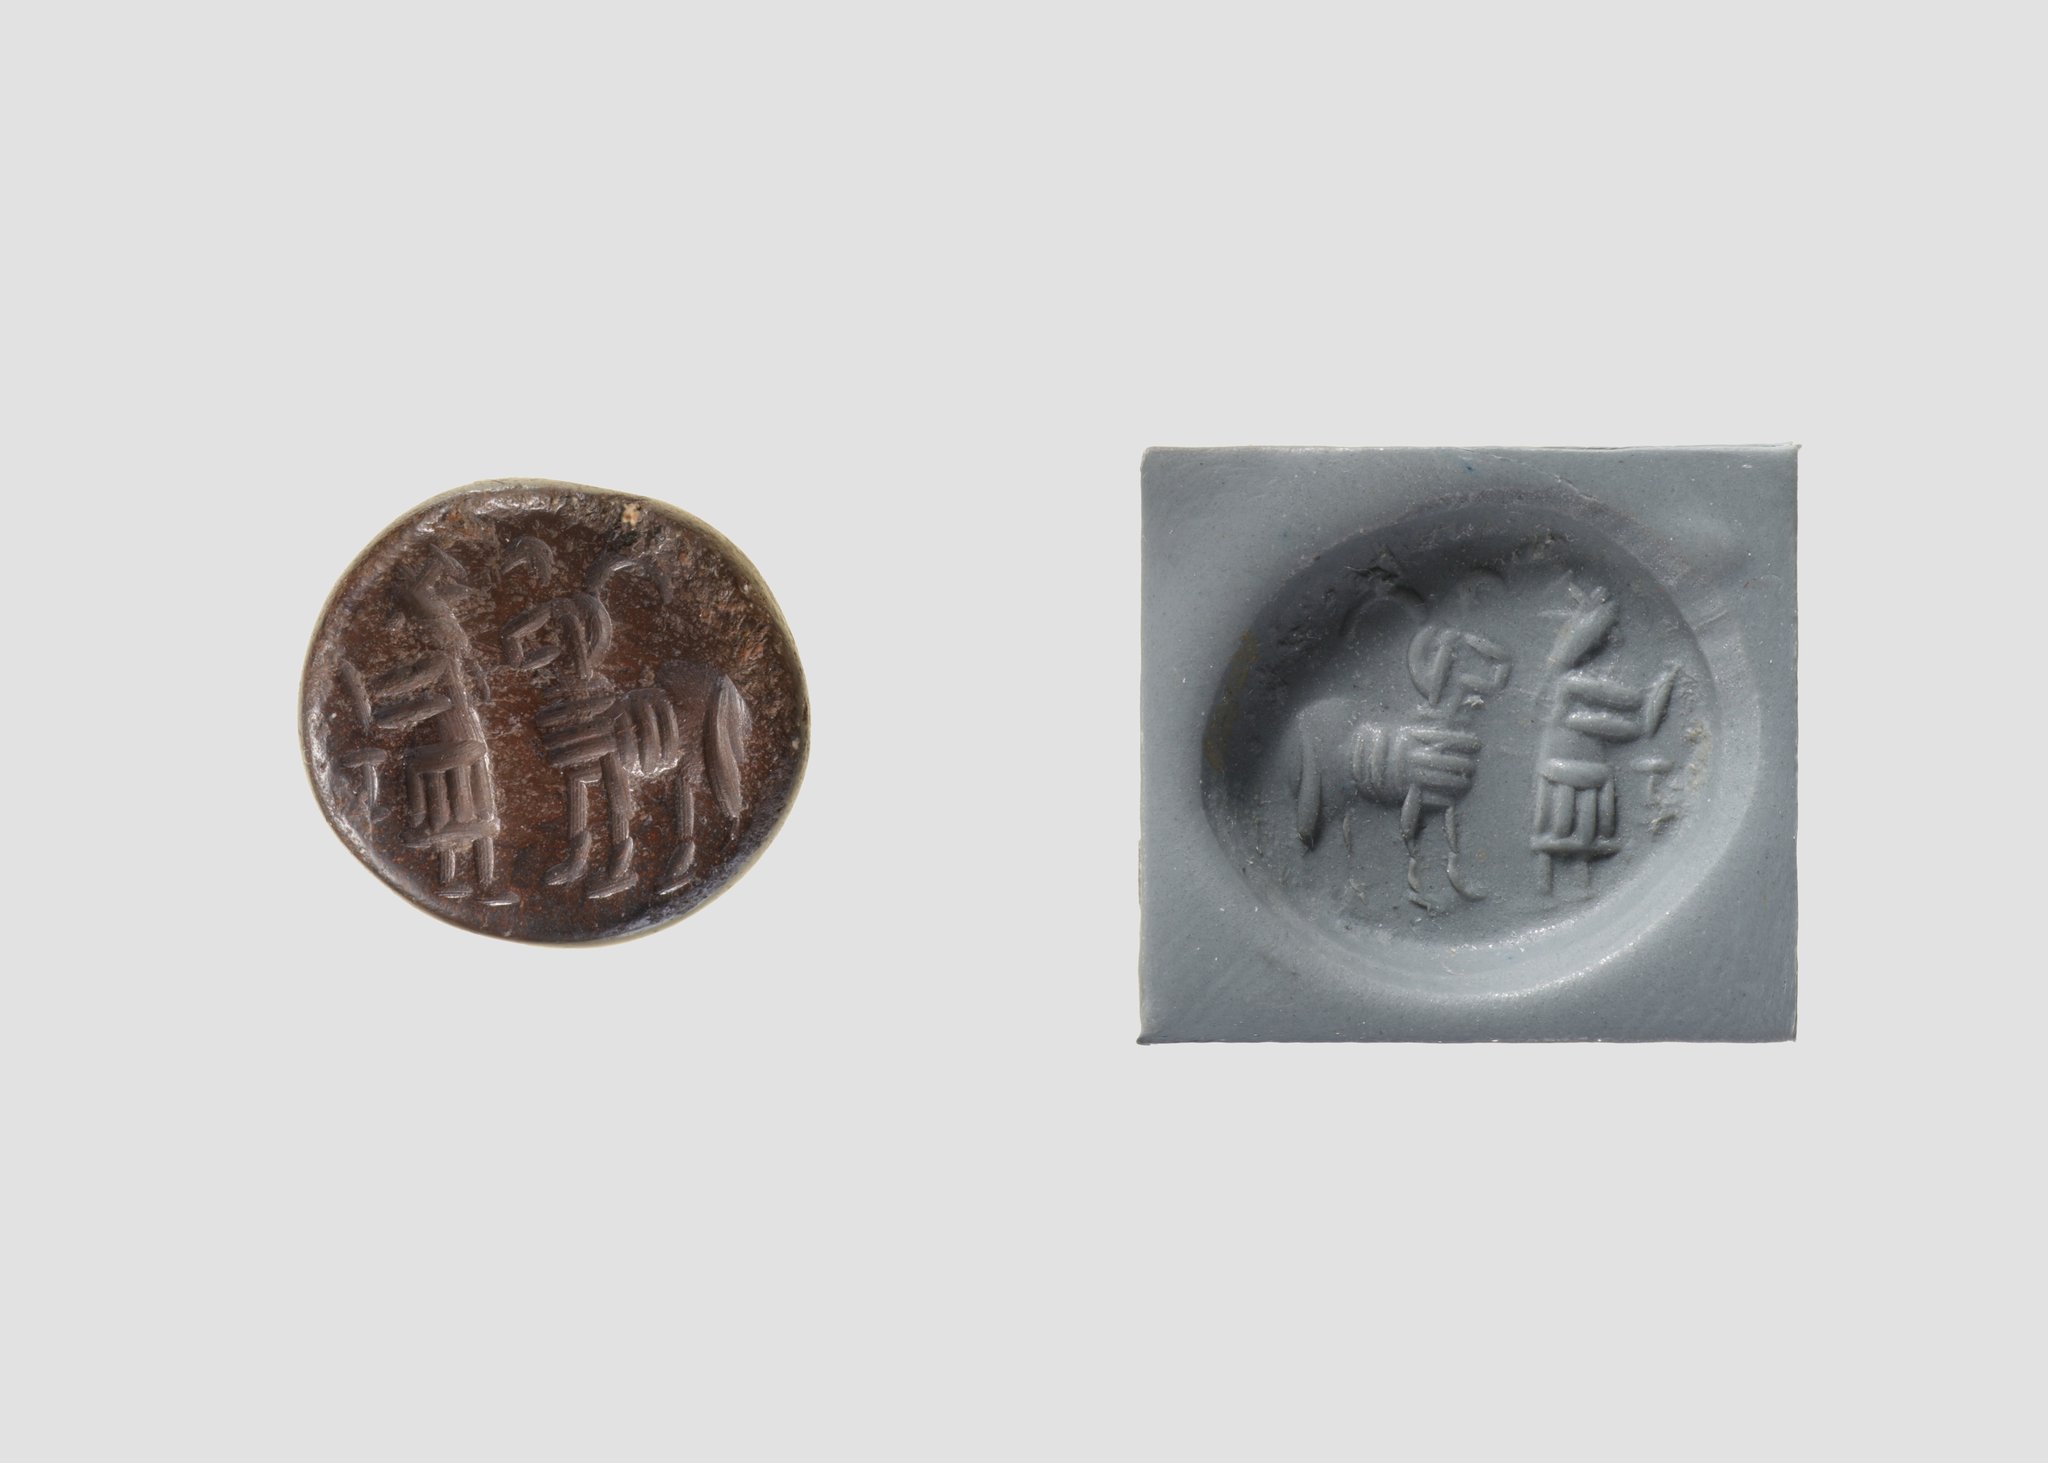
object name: stamp seal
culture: sasanian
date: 201-300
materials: mineral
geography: iran or mesopotamia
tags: animals